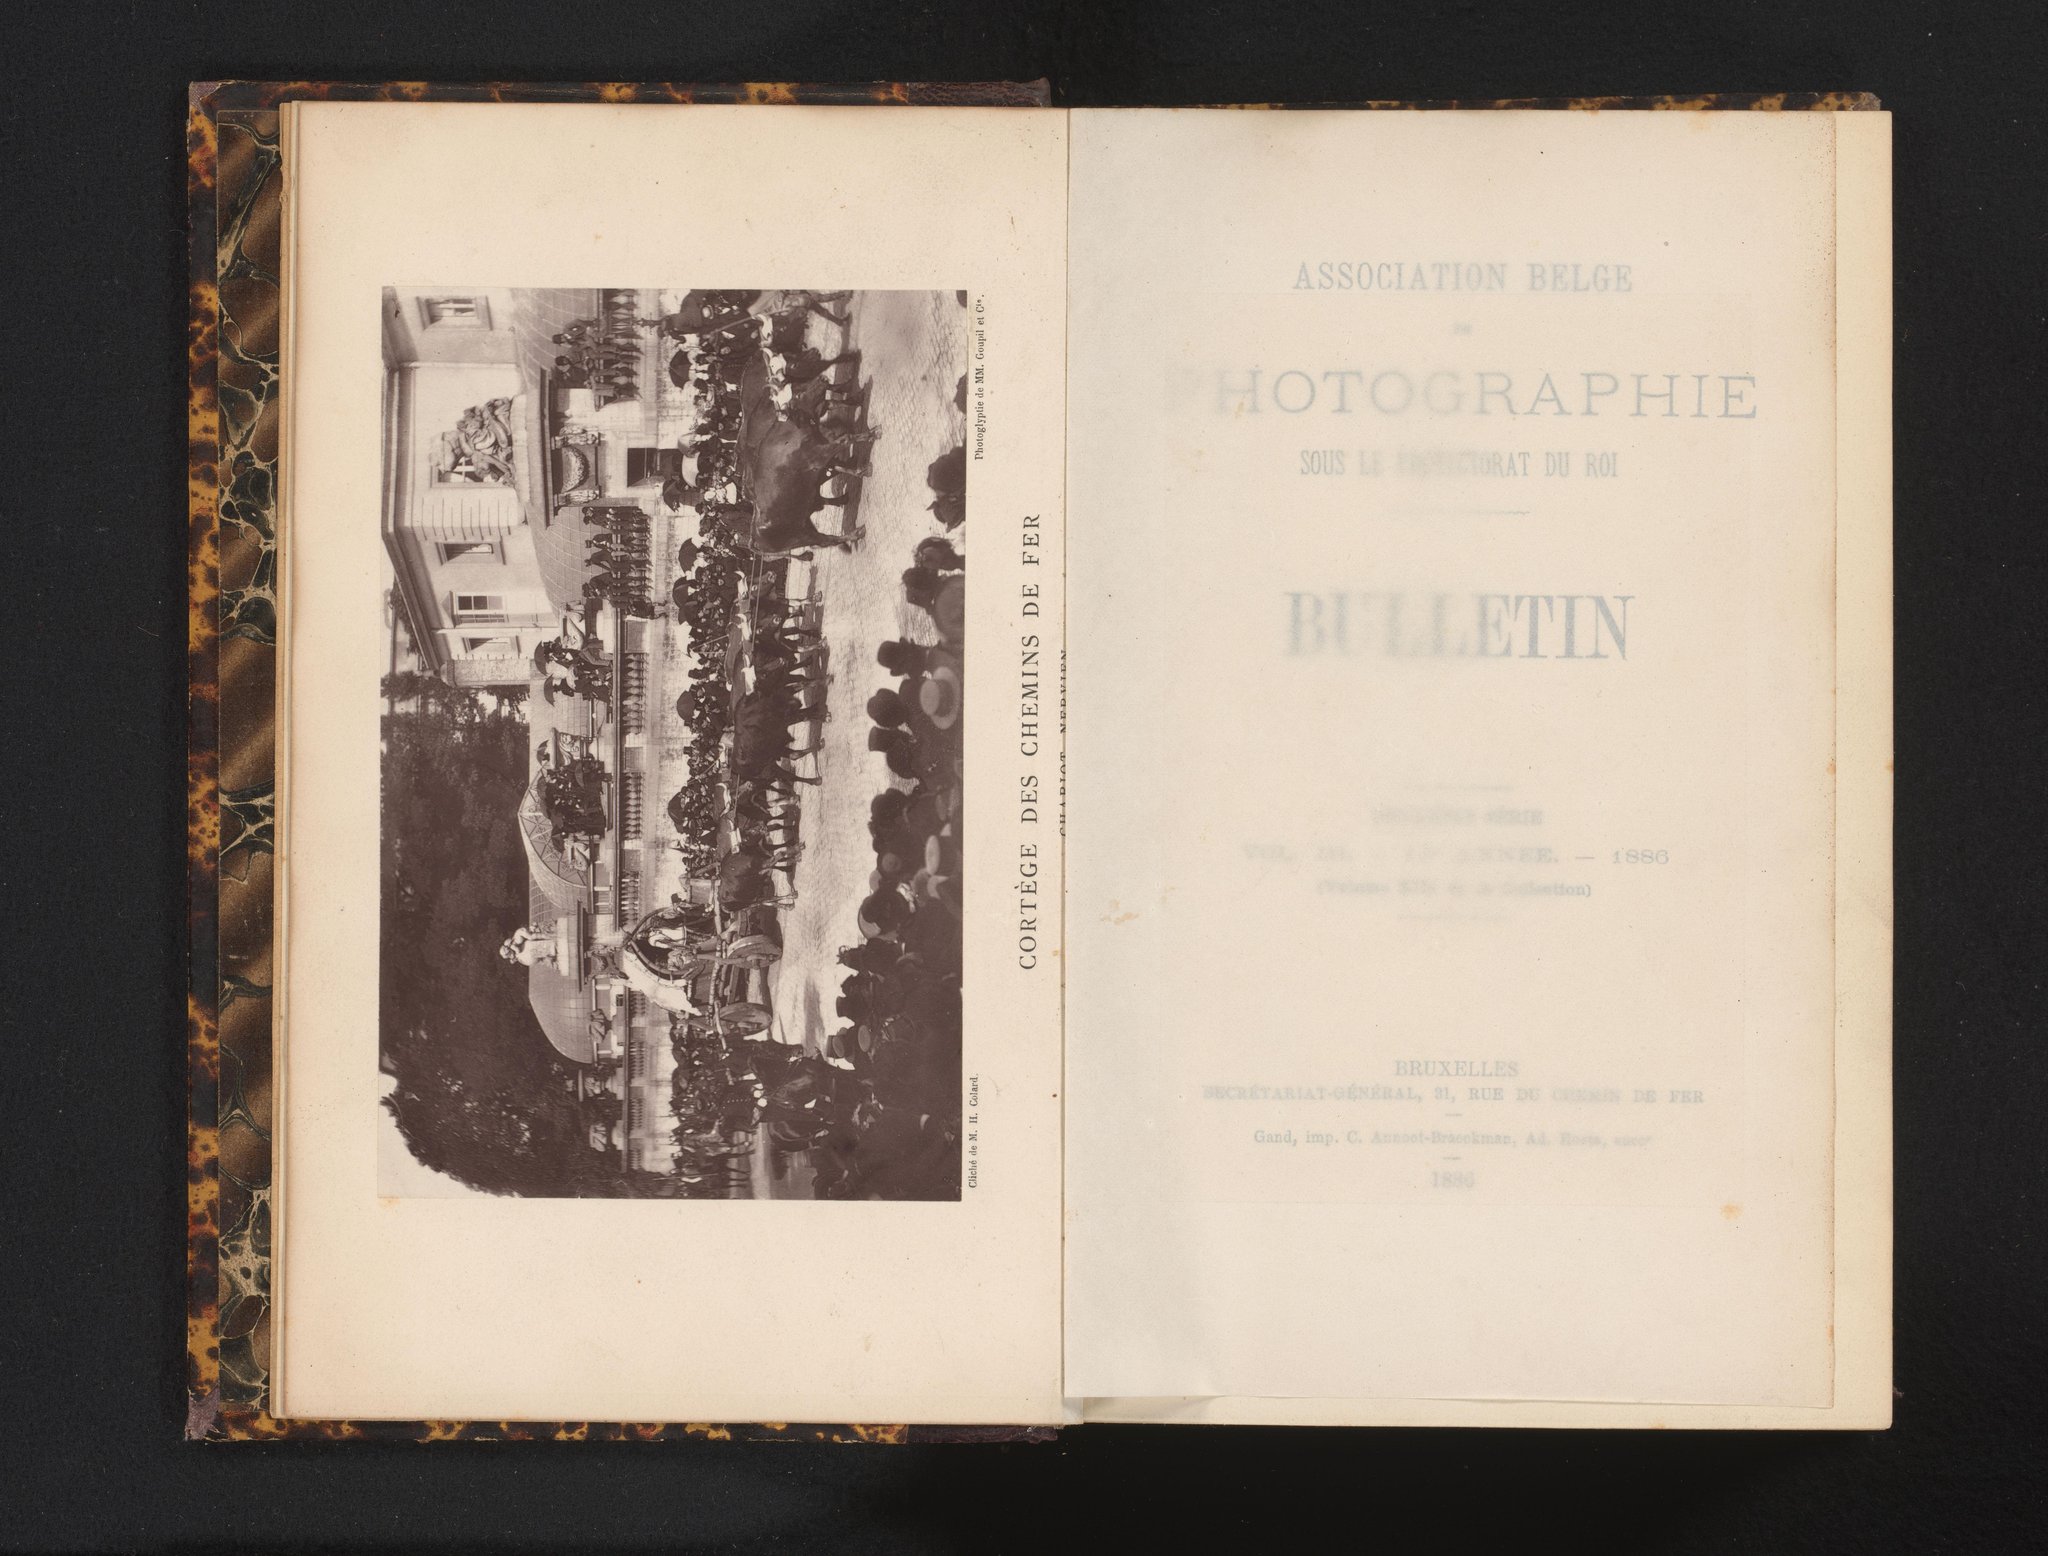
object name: photomechanical print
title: Cortège des chemins de fer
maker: hector colard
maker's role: fotograaf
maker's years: 1851-1923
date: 1881-1886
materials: paper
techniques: woodburytype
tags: animal traction, animal-drawn vehicle (carriage etc.), public festivities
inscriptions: inscription: ‘Chariot Nervien’